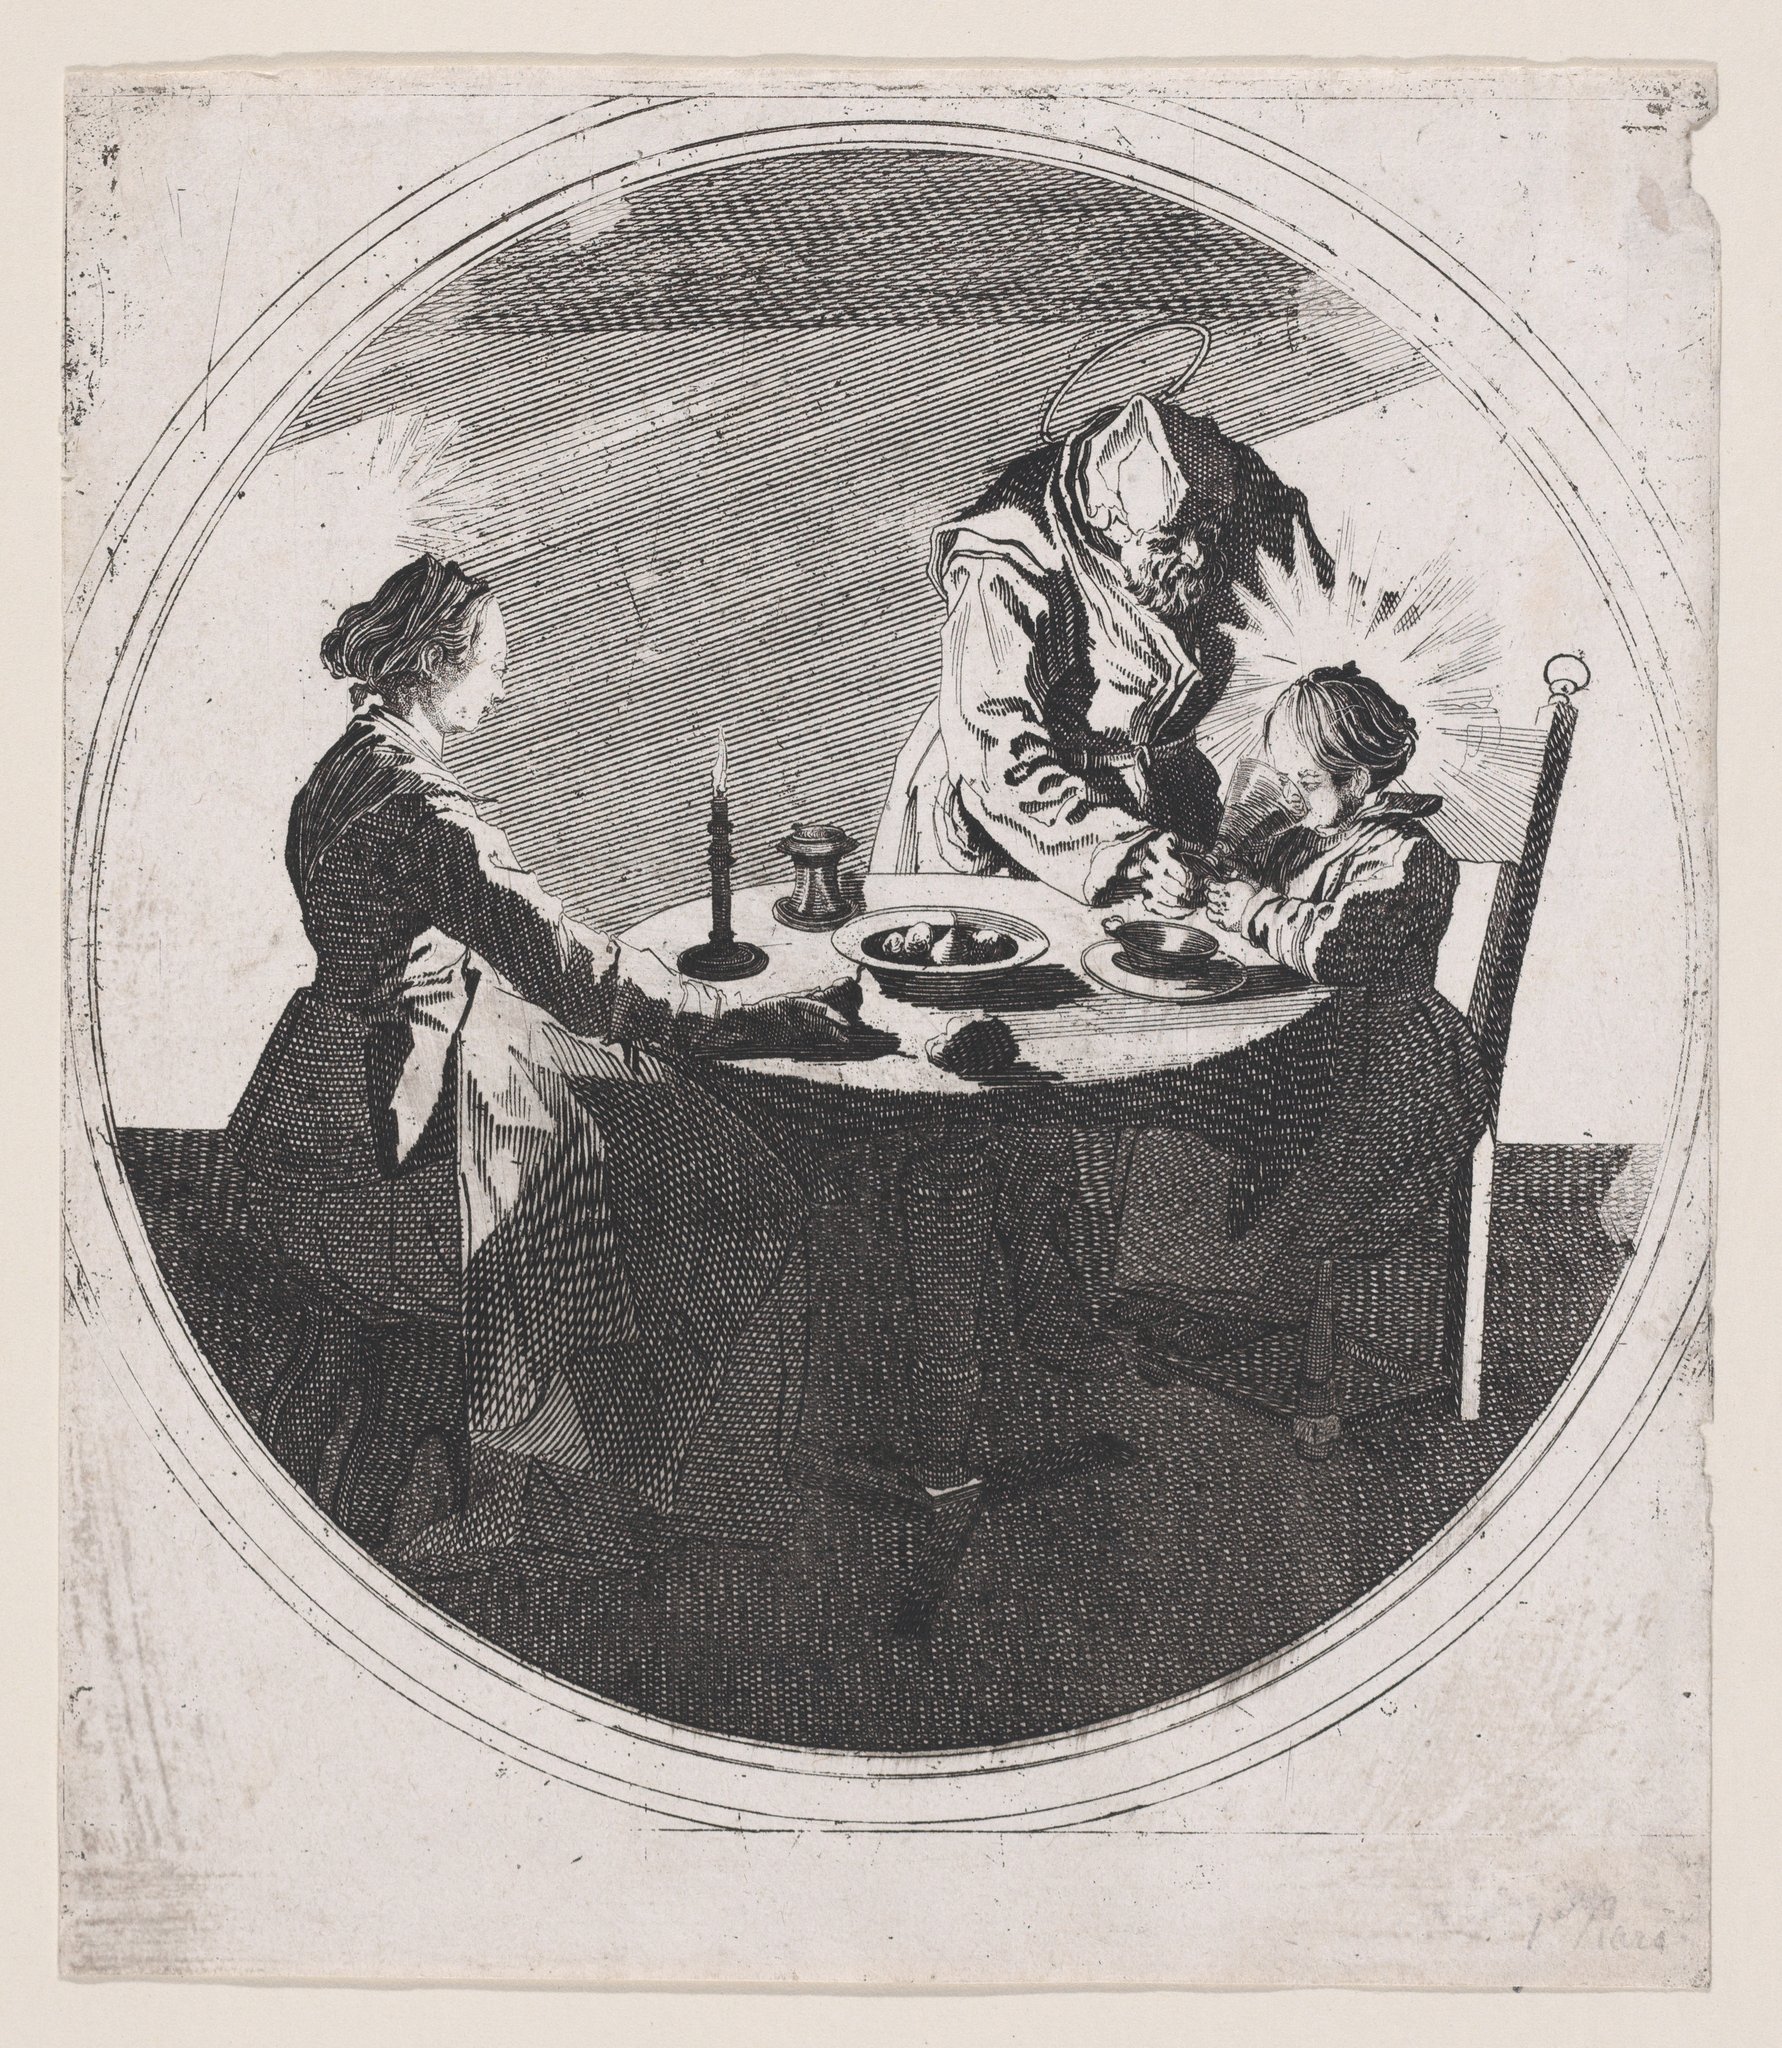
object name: print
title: Copy of Le Benedicite, estampe appelée aussi La Sainte Famille a Table et St. Joseph Faisant Boire L'Enfant Jésus (The Grace, also called The Holy Family at the Table and St. Joseph Giving the Christ Child a Drink)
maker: Anonymous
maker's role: artist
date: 1601-1700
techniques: etching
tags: food,holy family,virgin mary,jesus,drinking,eating,joseph